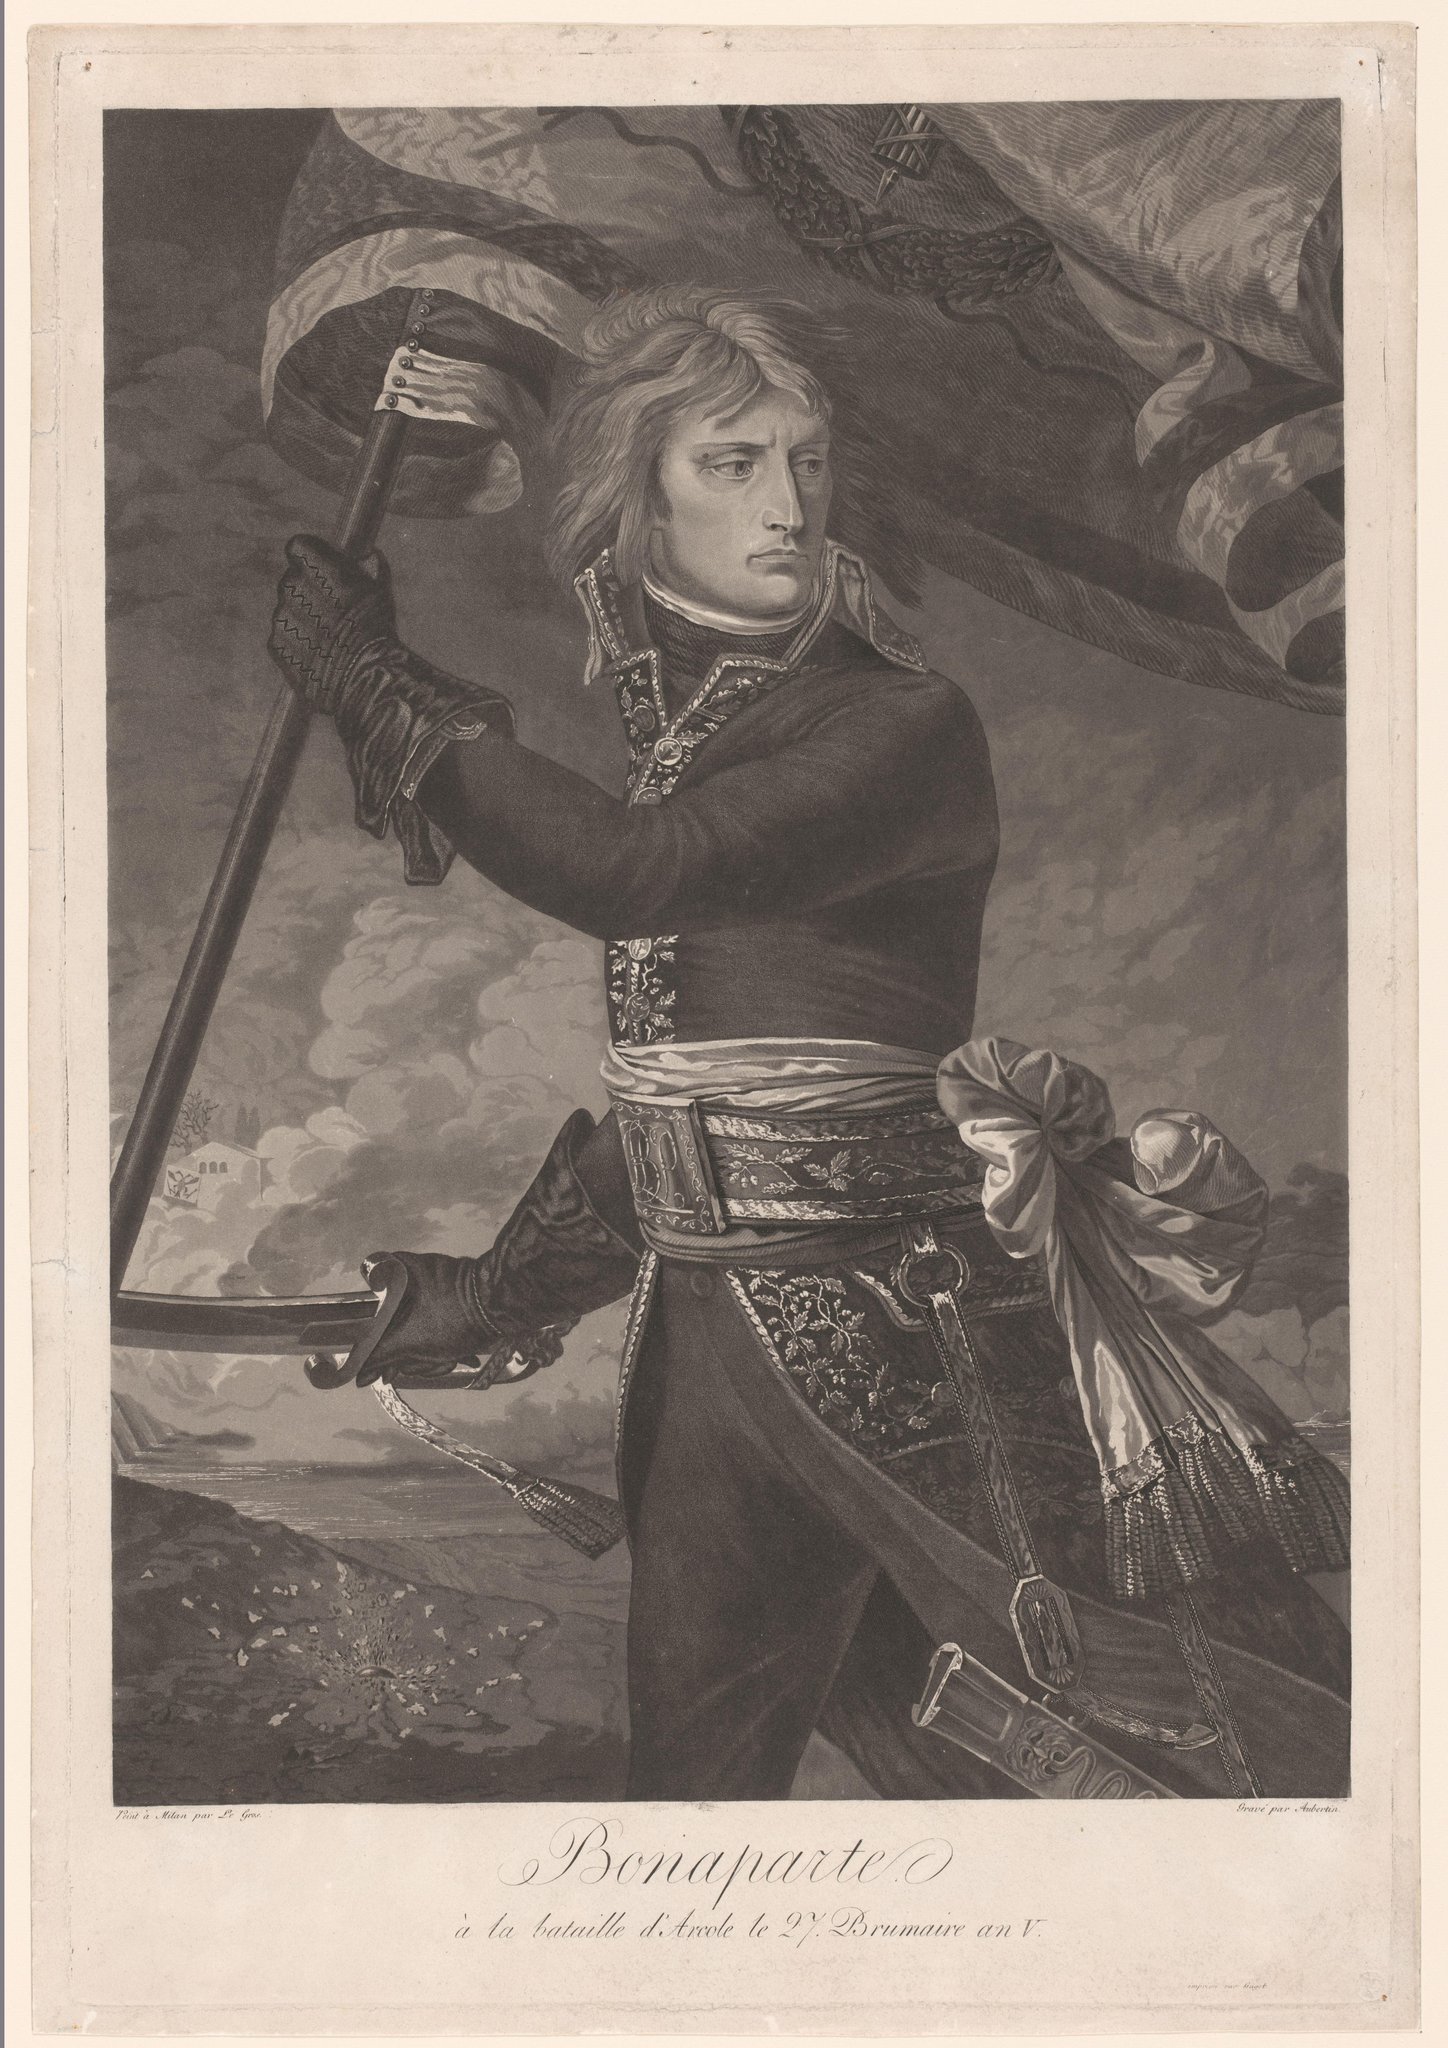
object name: print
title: Portret van Napoleon Bonaparte bij de slag van Arcole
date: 1783-1821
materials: paper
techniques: aquatint, etching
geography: france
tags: napoleon i (emperor of the french), historical persons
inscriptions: collector's mark: ‘W[...]’, collector's mark: Lugt 2228